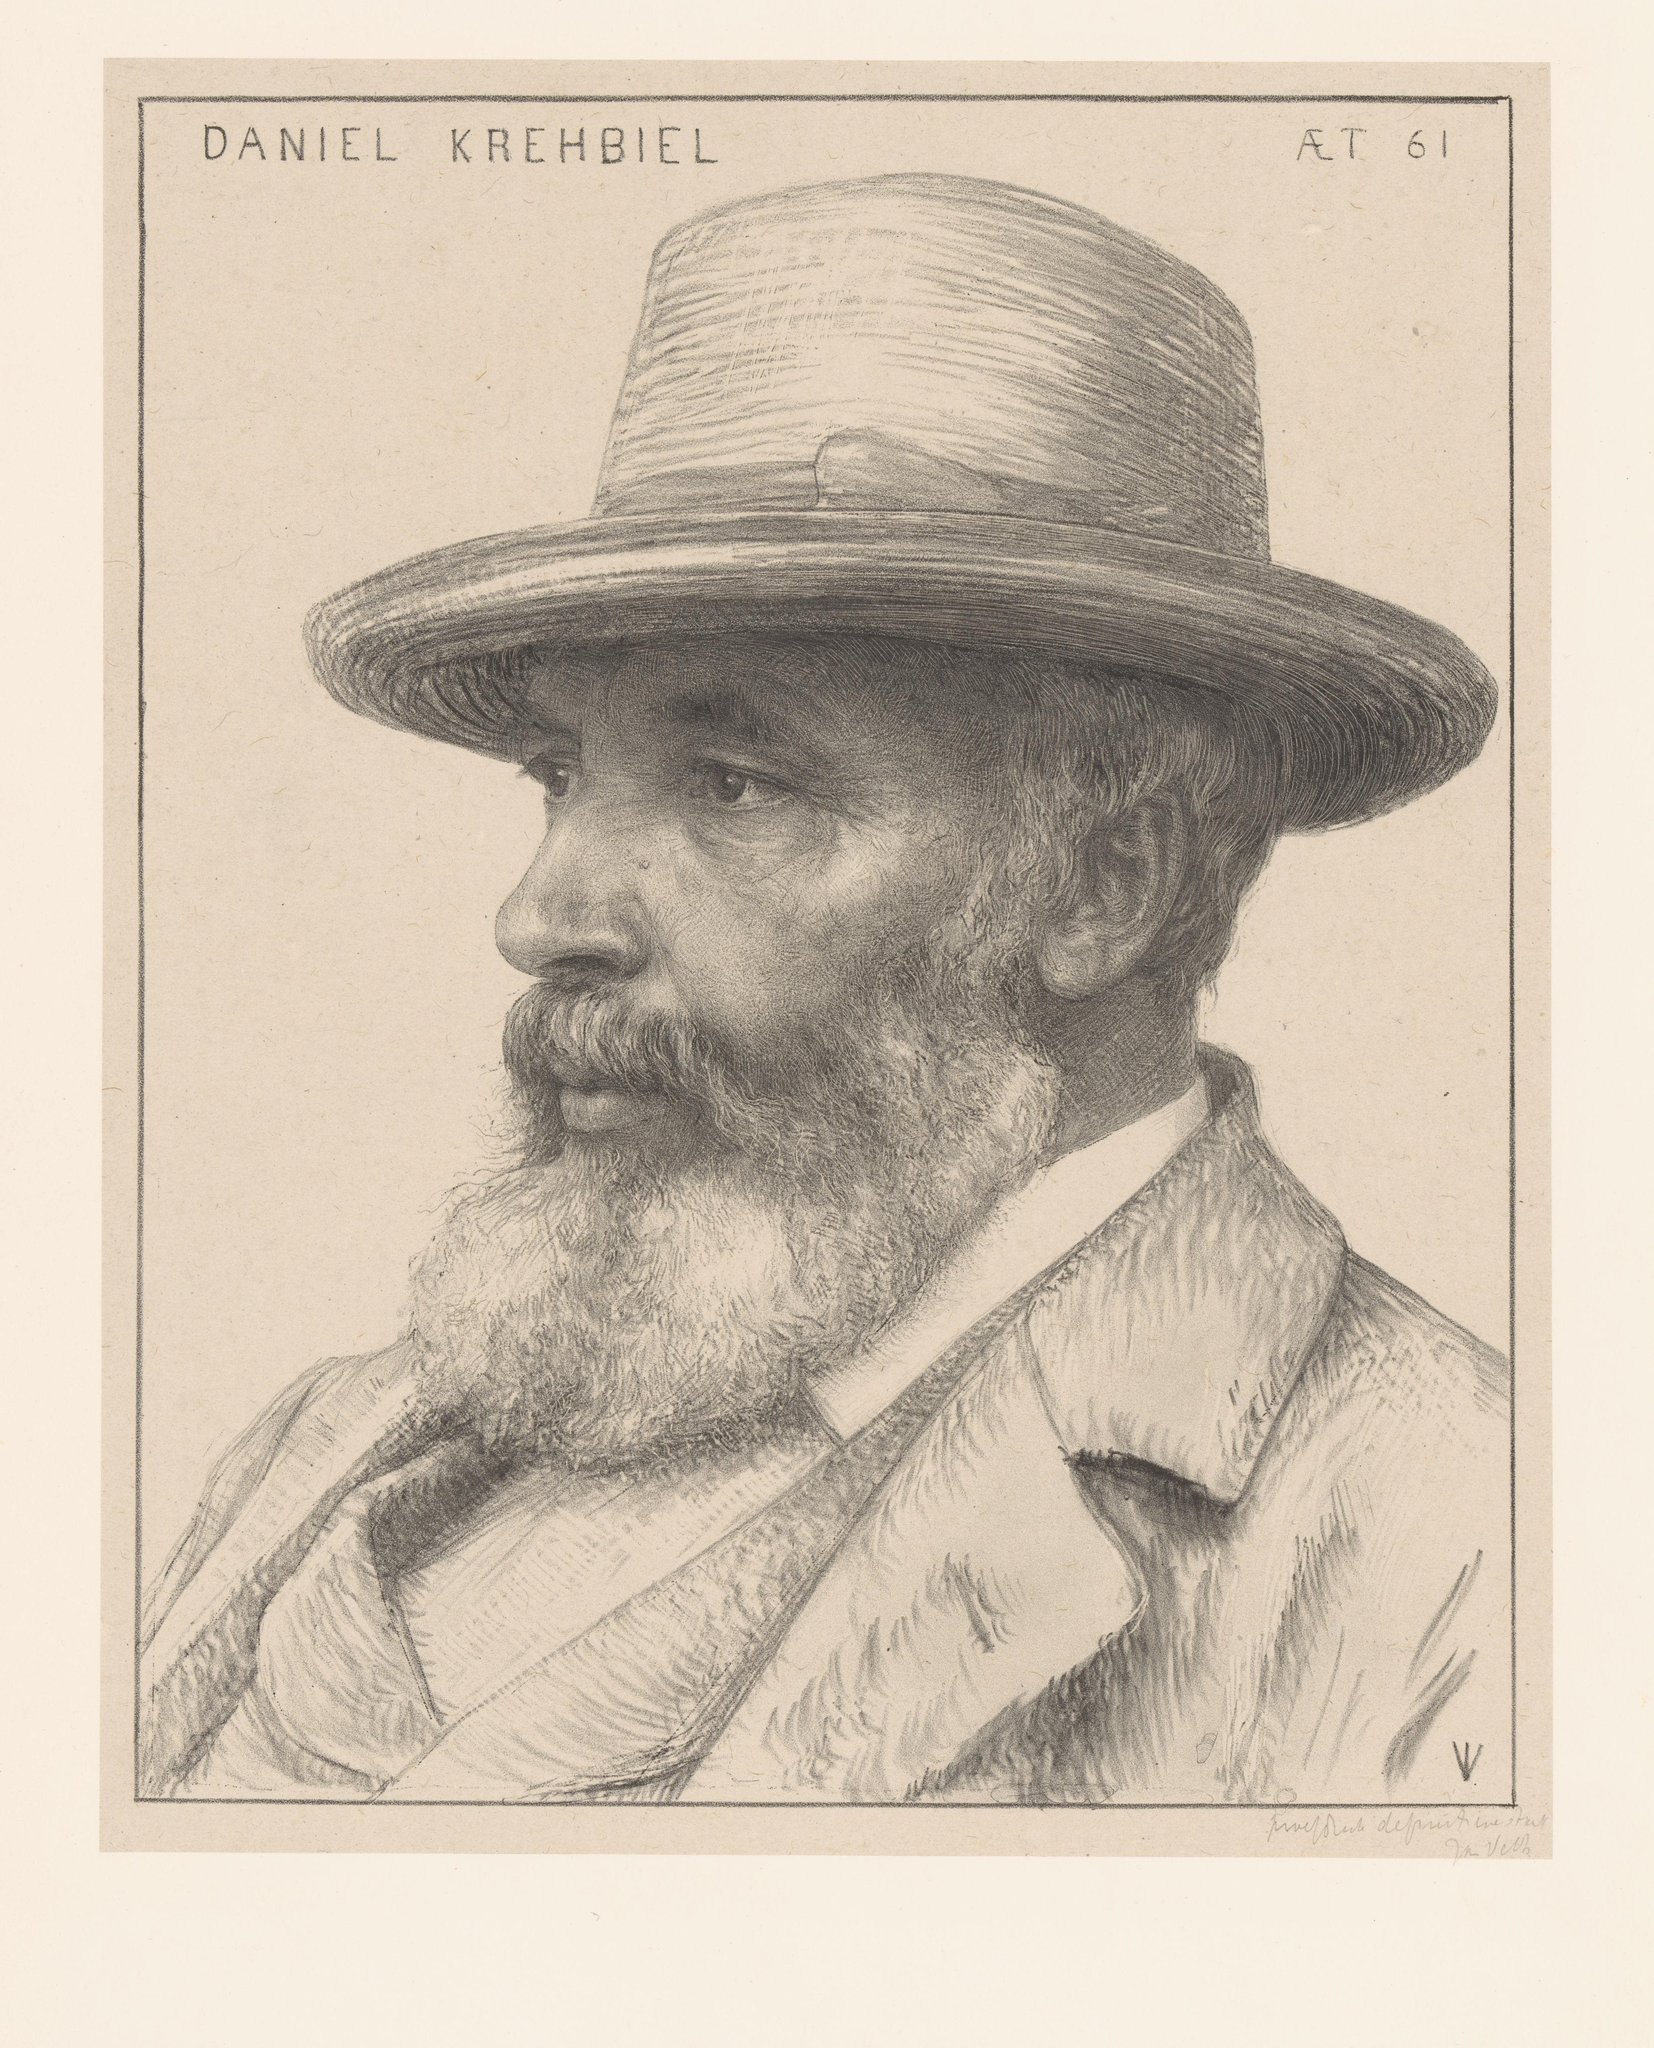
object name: print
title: Portret van Daniel Krehbiel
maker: jan veth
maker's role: designer, draughtsman, painter, print maker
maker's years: 1864-1925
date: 1904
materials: paper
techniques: lithograph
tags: historical persons (+ (full) bust portrait)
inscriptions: inscription: ‘proefdruk definitieve staat / Jan Veth’, collector's mark: Lugt 2228